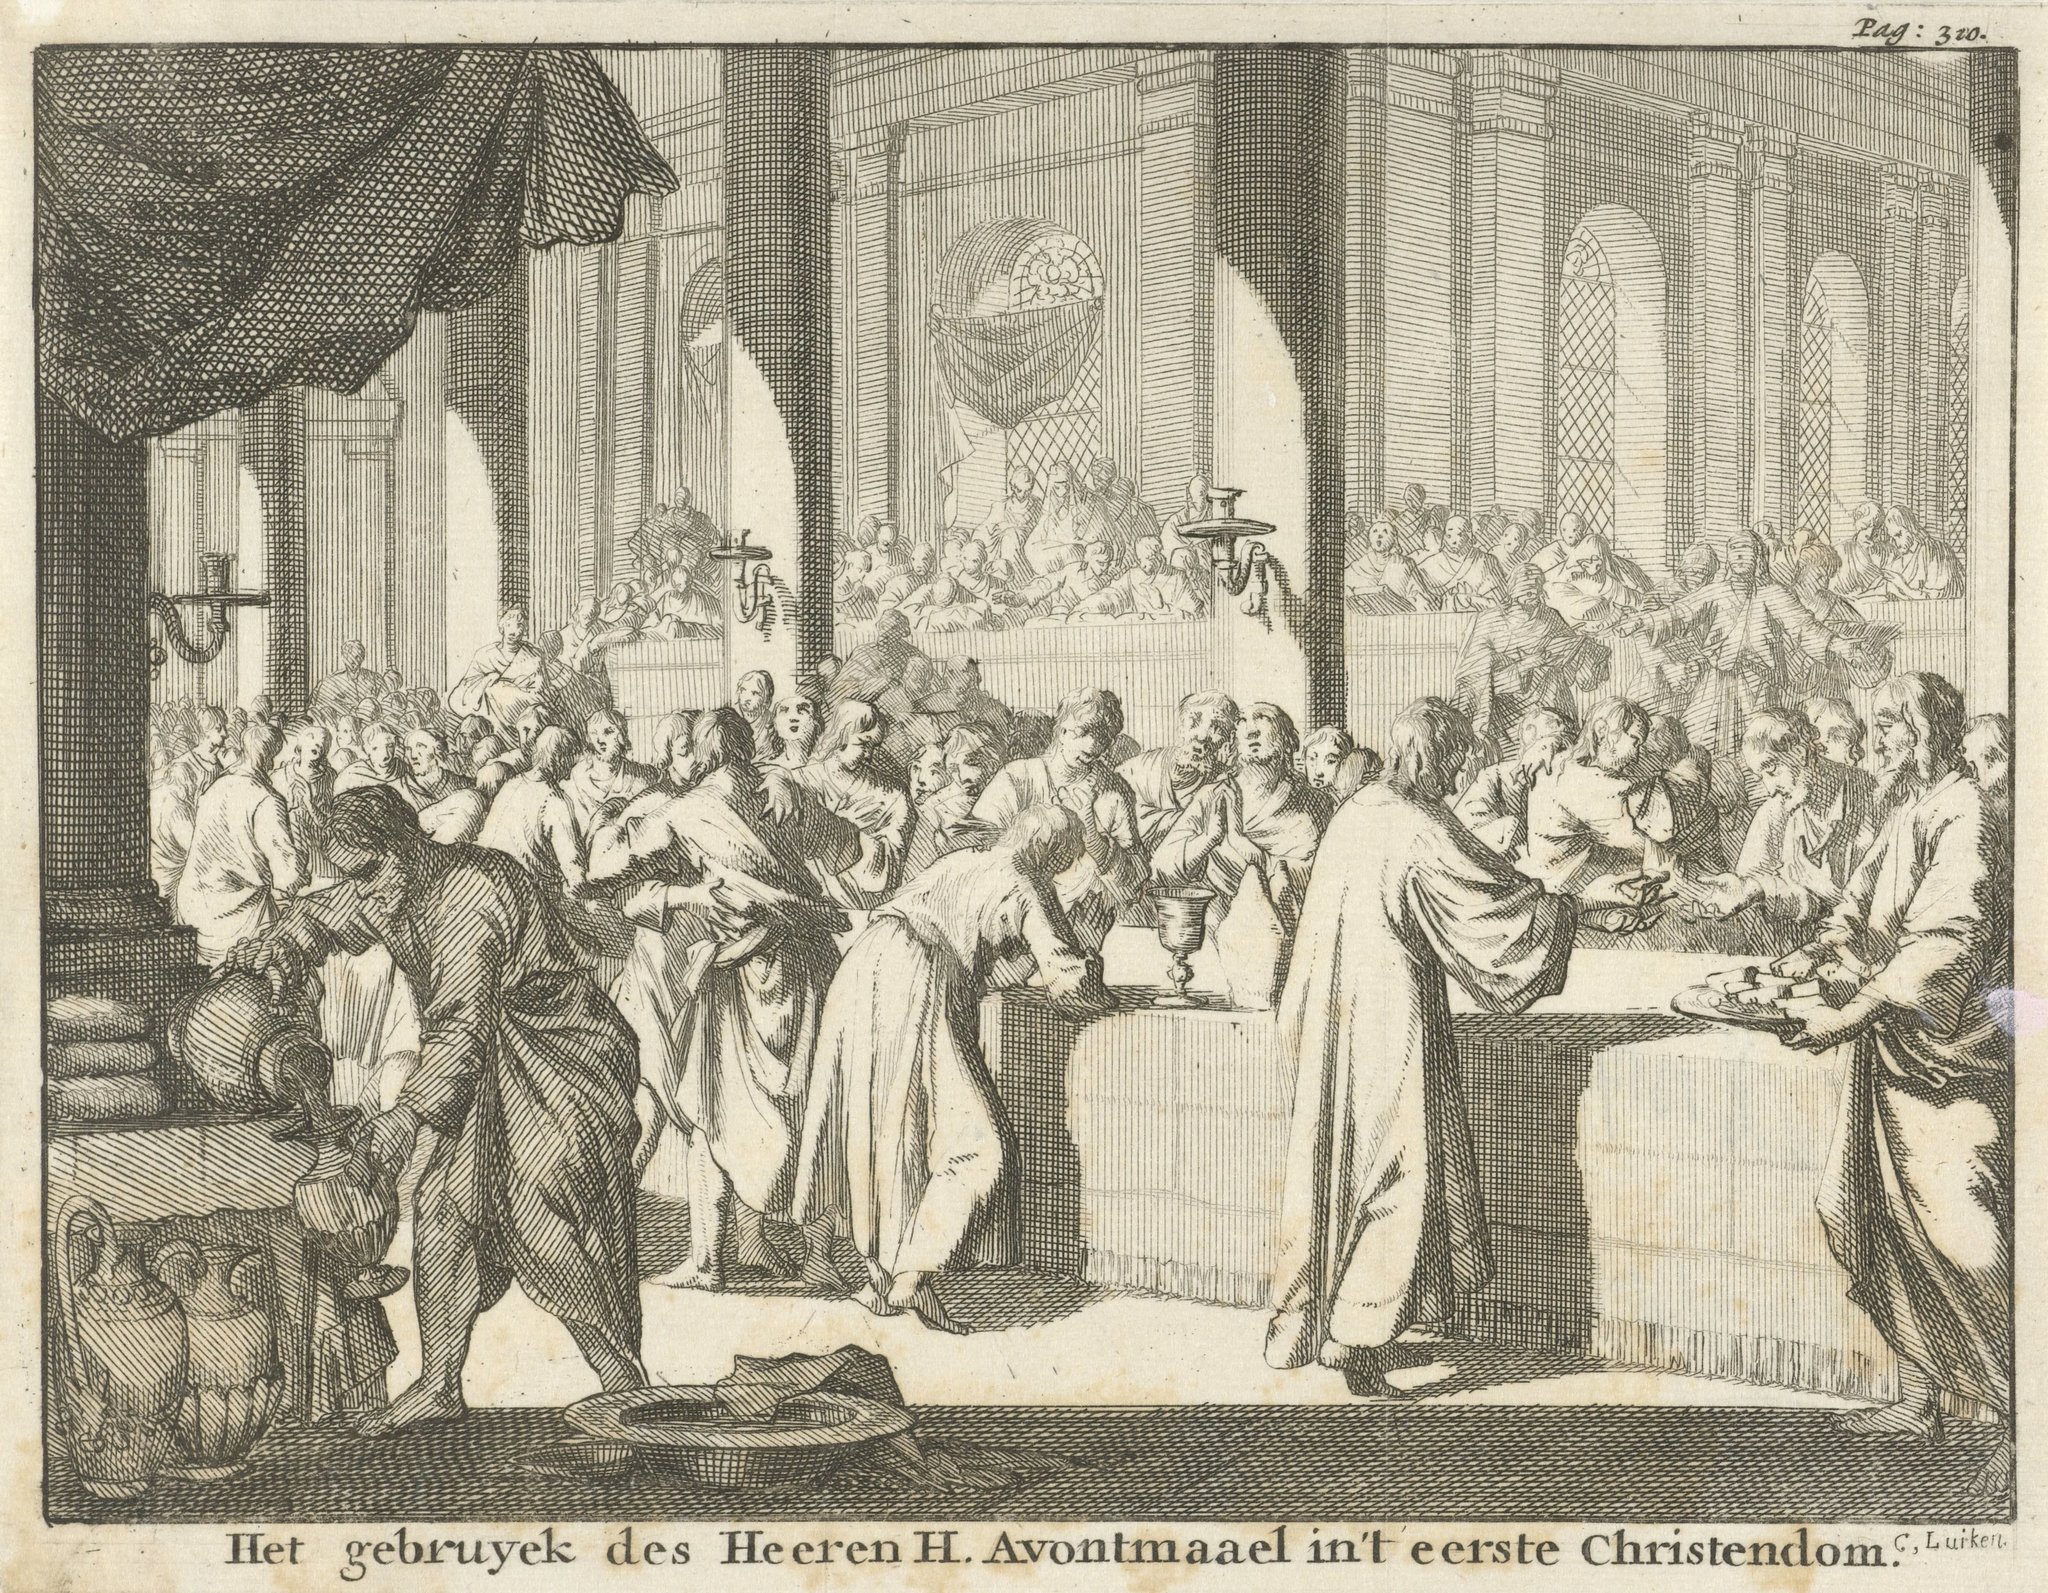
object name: book illustration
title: Eucharistieviering in een kerk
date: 1694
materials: paper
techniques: etching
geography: amsterdam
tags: holy communion ~ protestant service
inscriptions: collector's mark: Lugt 2228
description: Illustratie uit: Cave, William. De godsdienst der oude christenen. Amsterdam: Arnoldus van Ravestein, 1694.